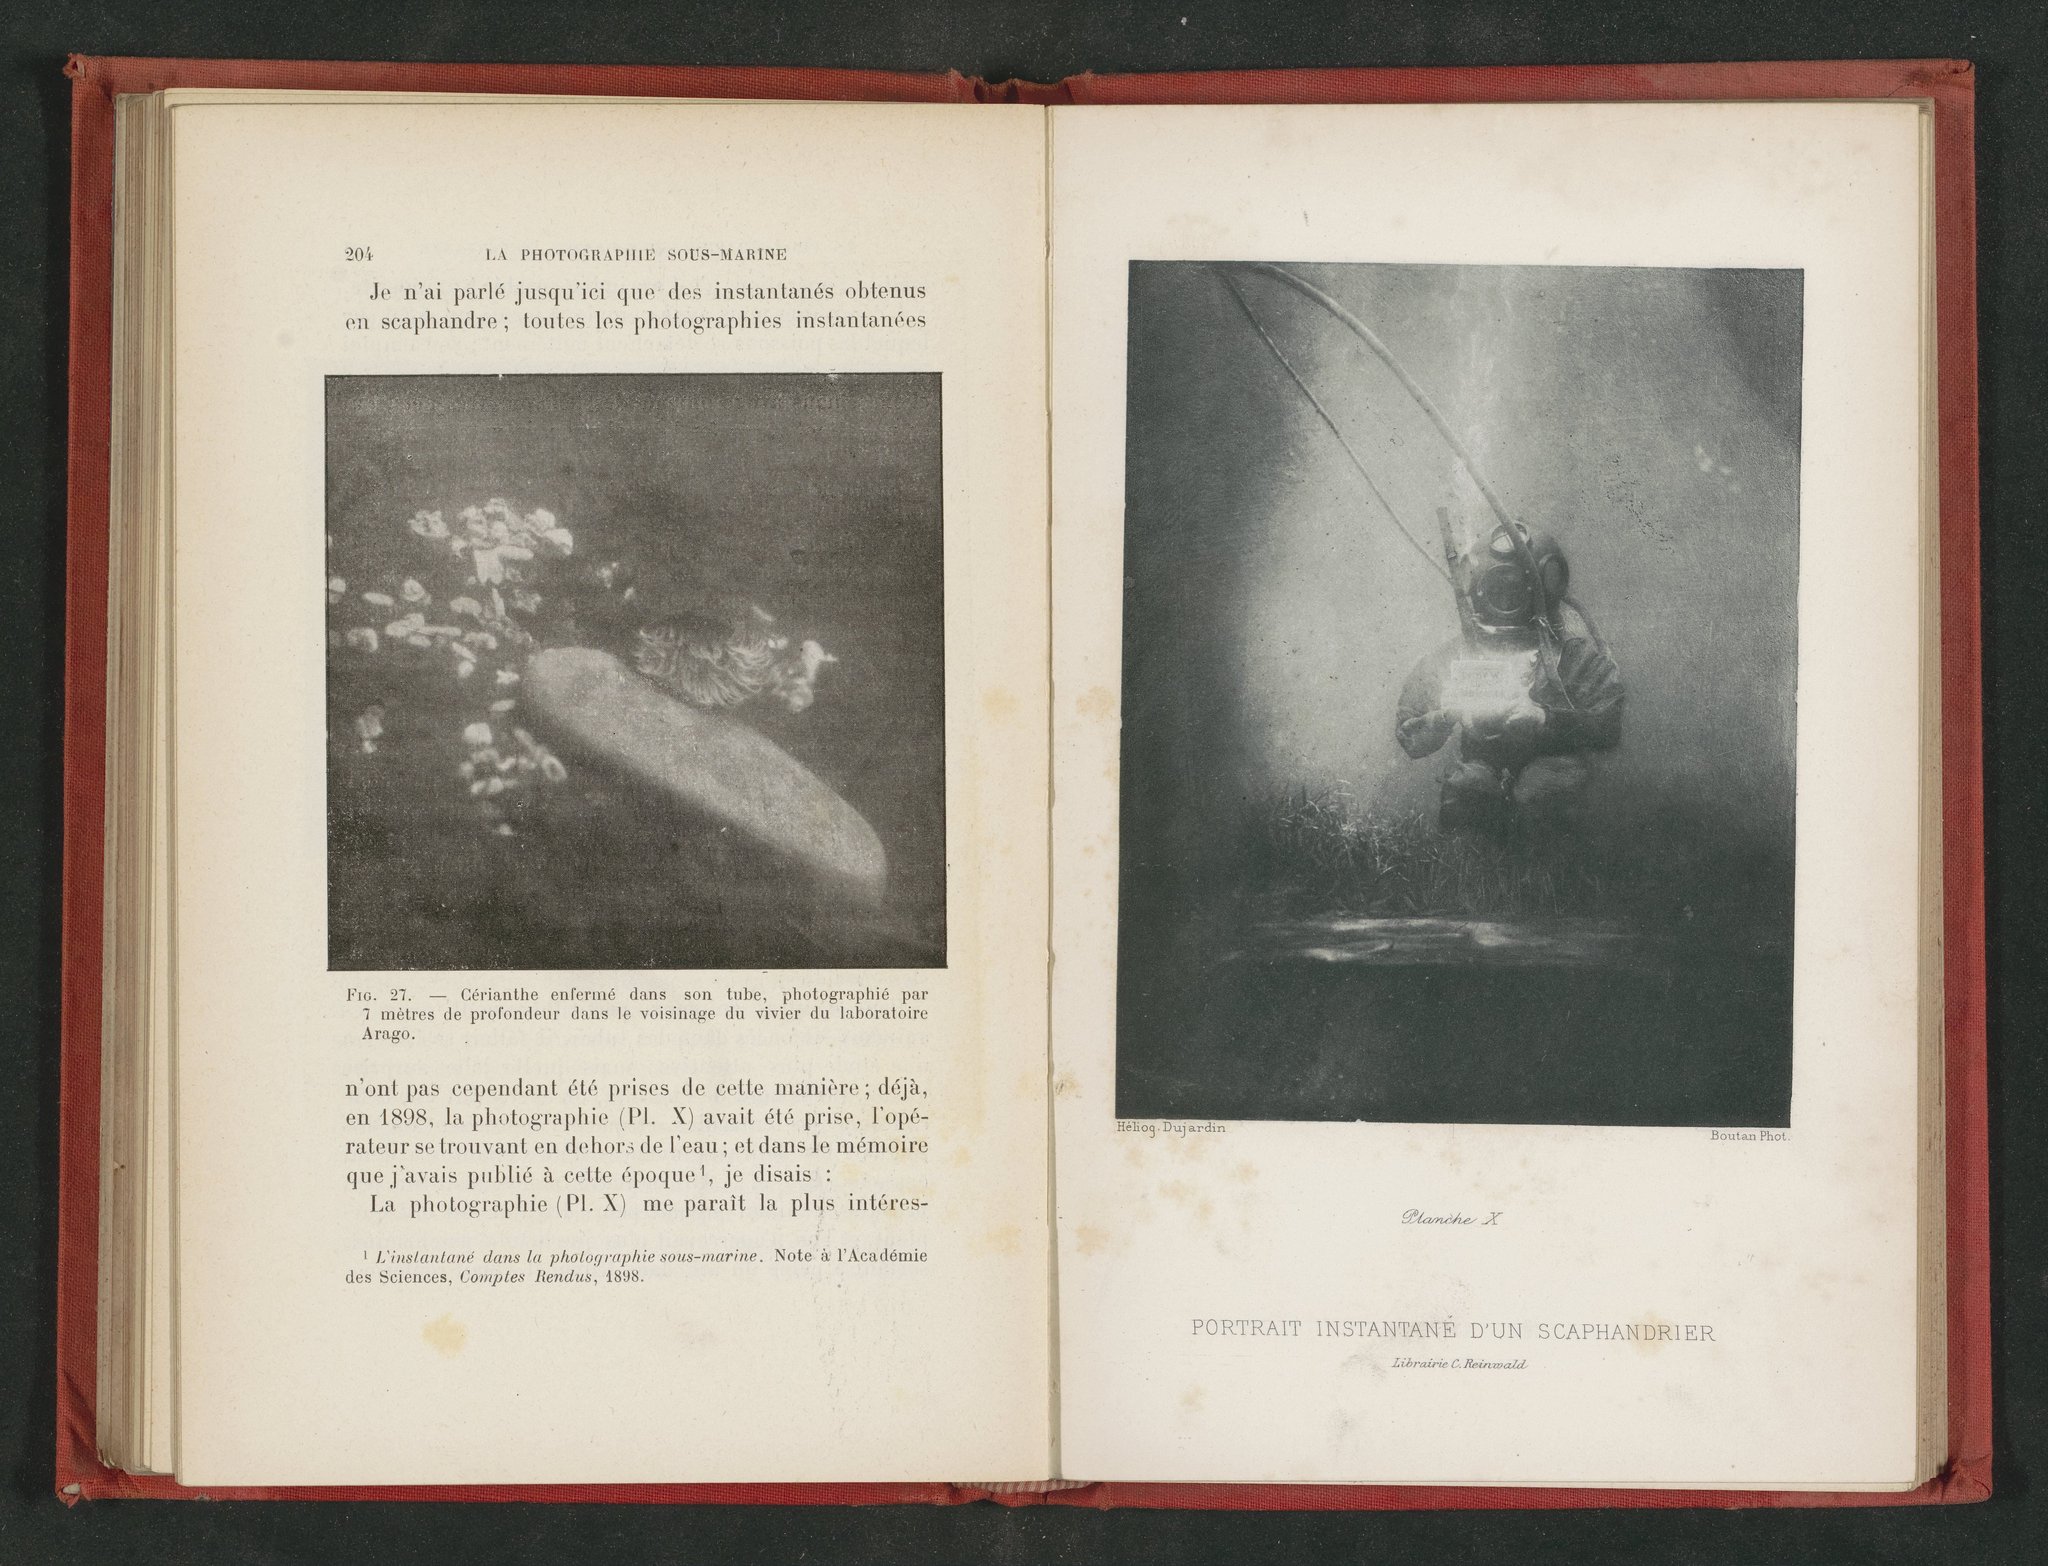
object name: photomechanical print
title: Duiker in duikuitrusting onderwater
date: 1890-1900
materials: paper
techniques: photoaquatint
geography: france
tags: deep-sea diving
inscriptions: number: ‘Planche X’, inscription: ‘Librairie C. Reinwald’